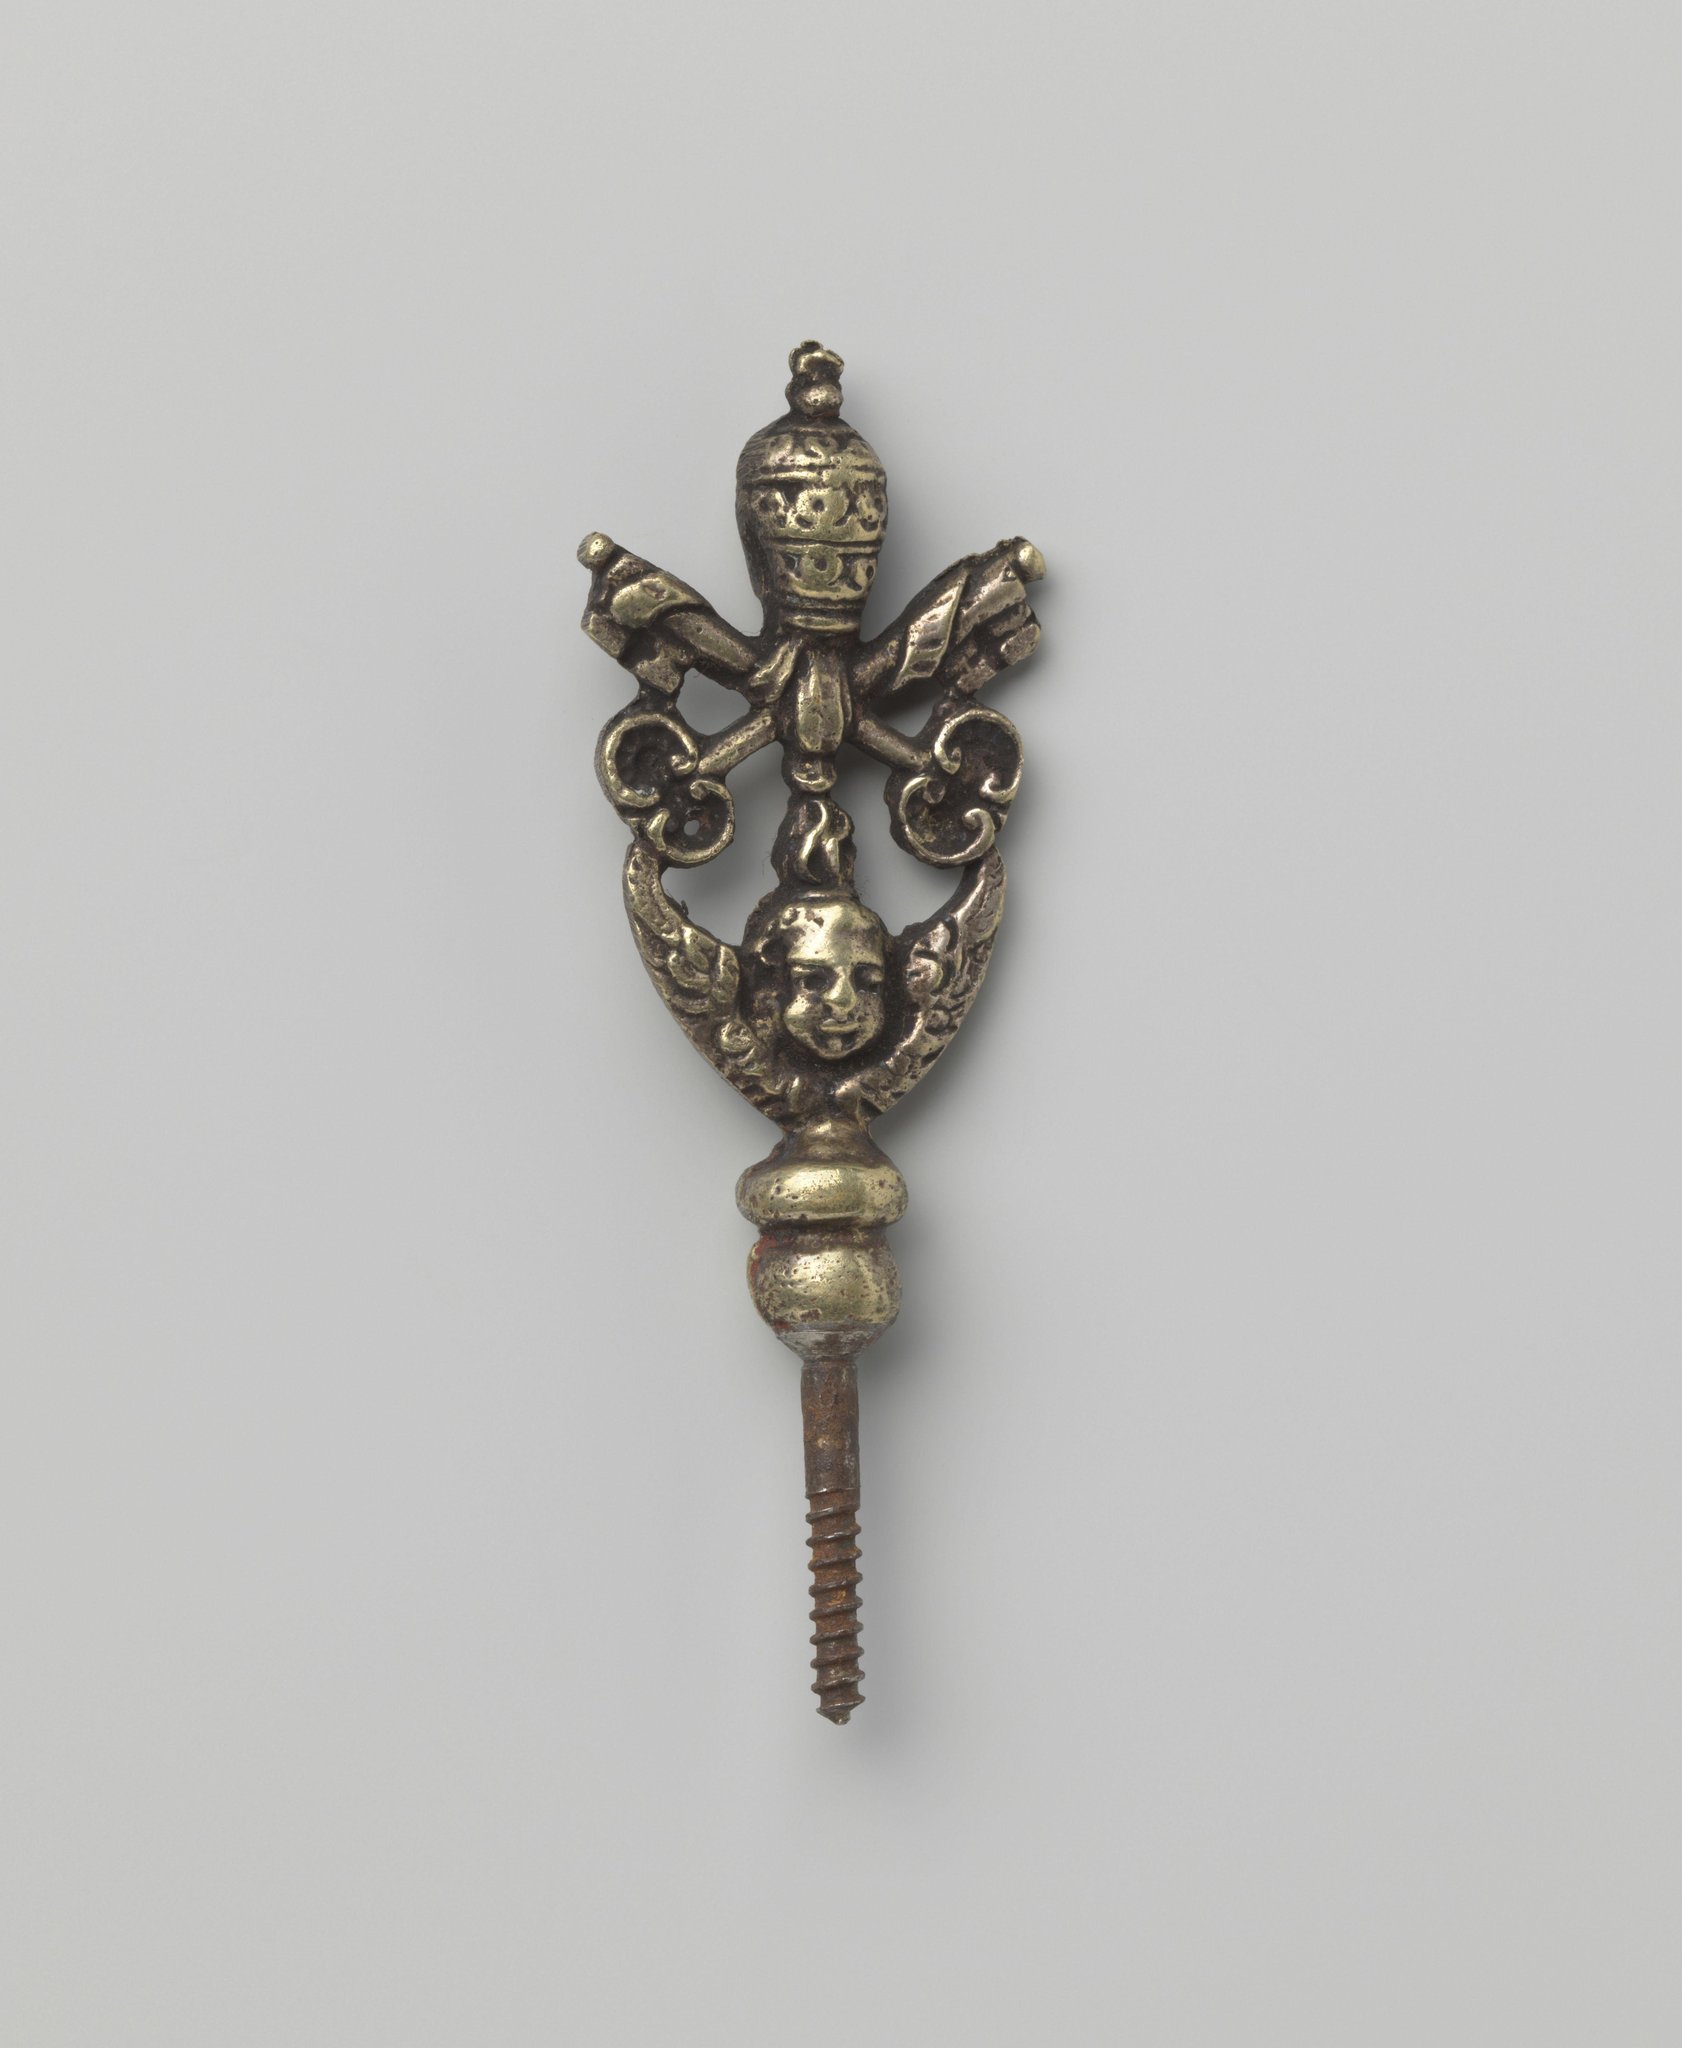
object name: handle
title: Handvat van verzilverd koper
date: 1700-1800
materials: copper, silver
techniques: silvering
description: Handvat van verzilverd koper, versierd met het Pauselijk wapen geplaatst op een cherubijnkopje.